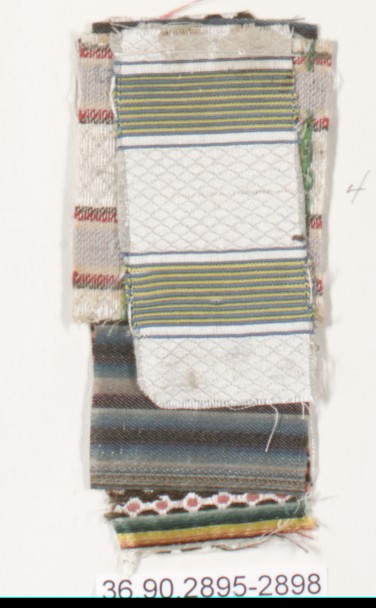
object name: piece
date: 1801-1900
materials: silk